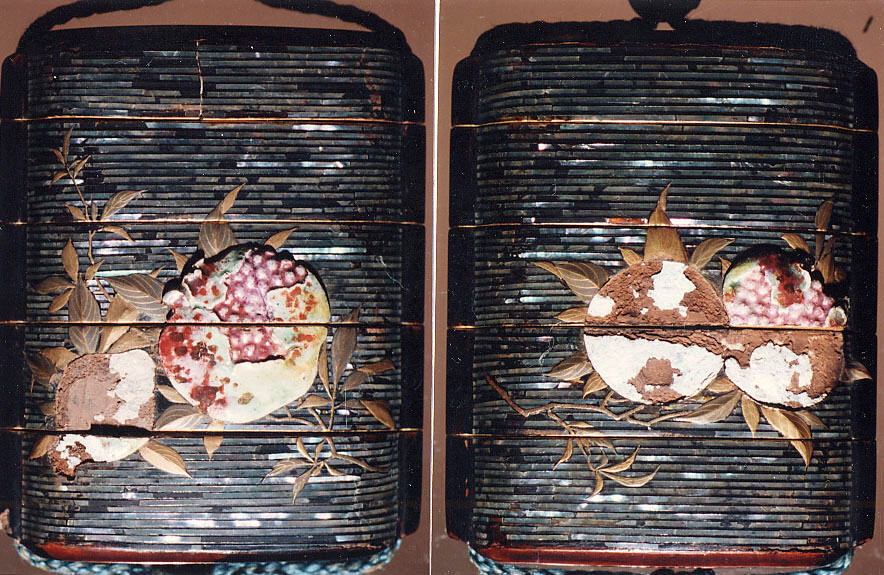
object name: inrō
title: Case (Inrō) with Design of Pomegranate Branches and Fruits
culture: japanese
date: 1801-1900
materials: ceramic, gold, lacquer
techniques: fundame, hiramakie, inlay, roiro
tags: pomegranates